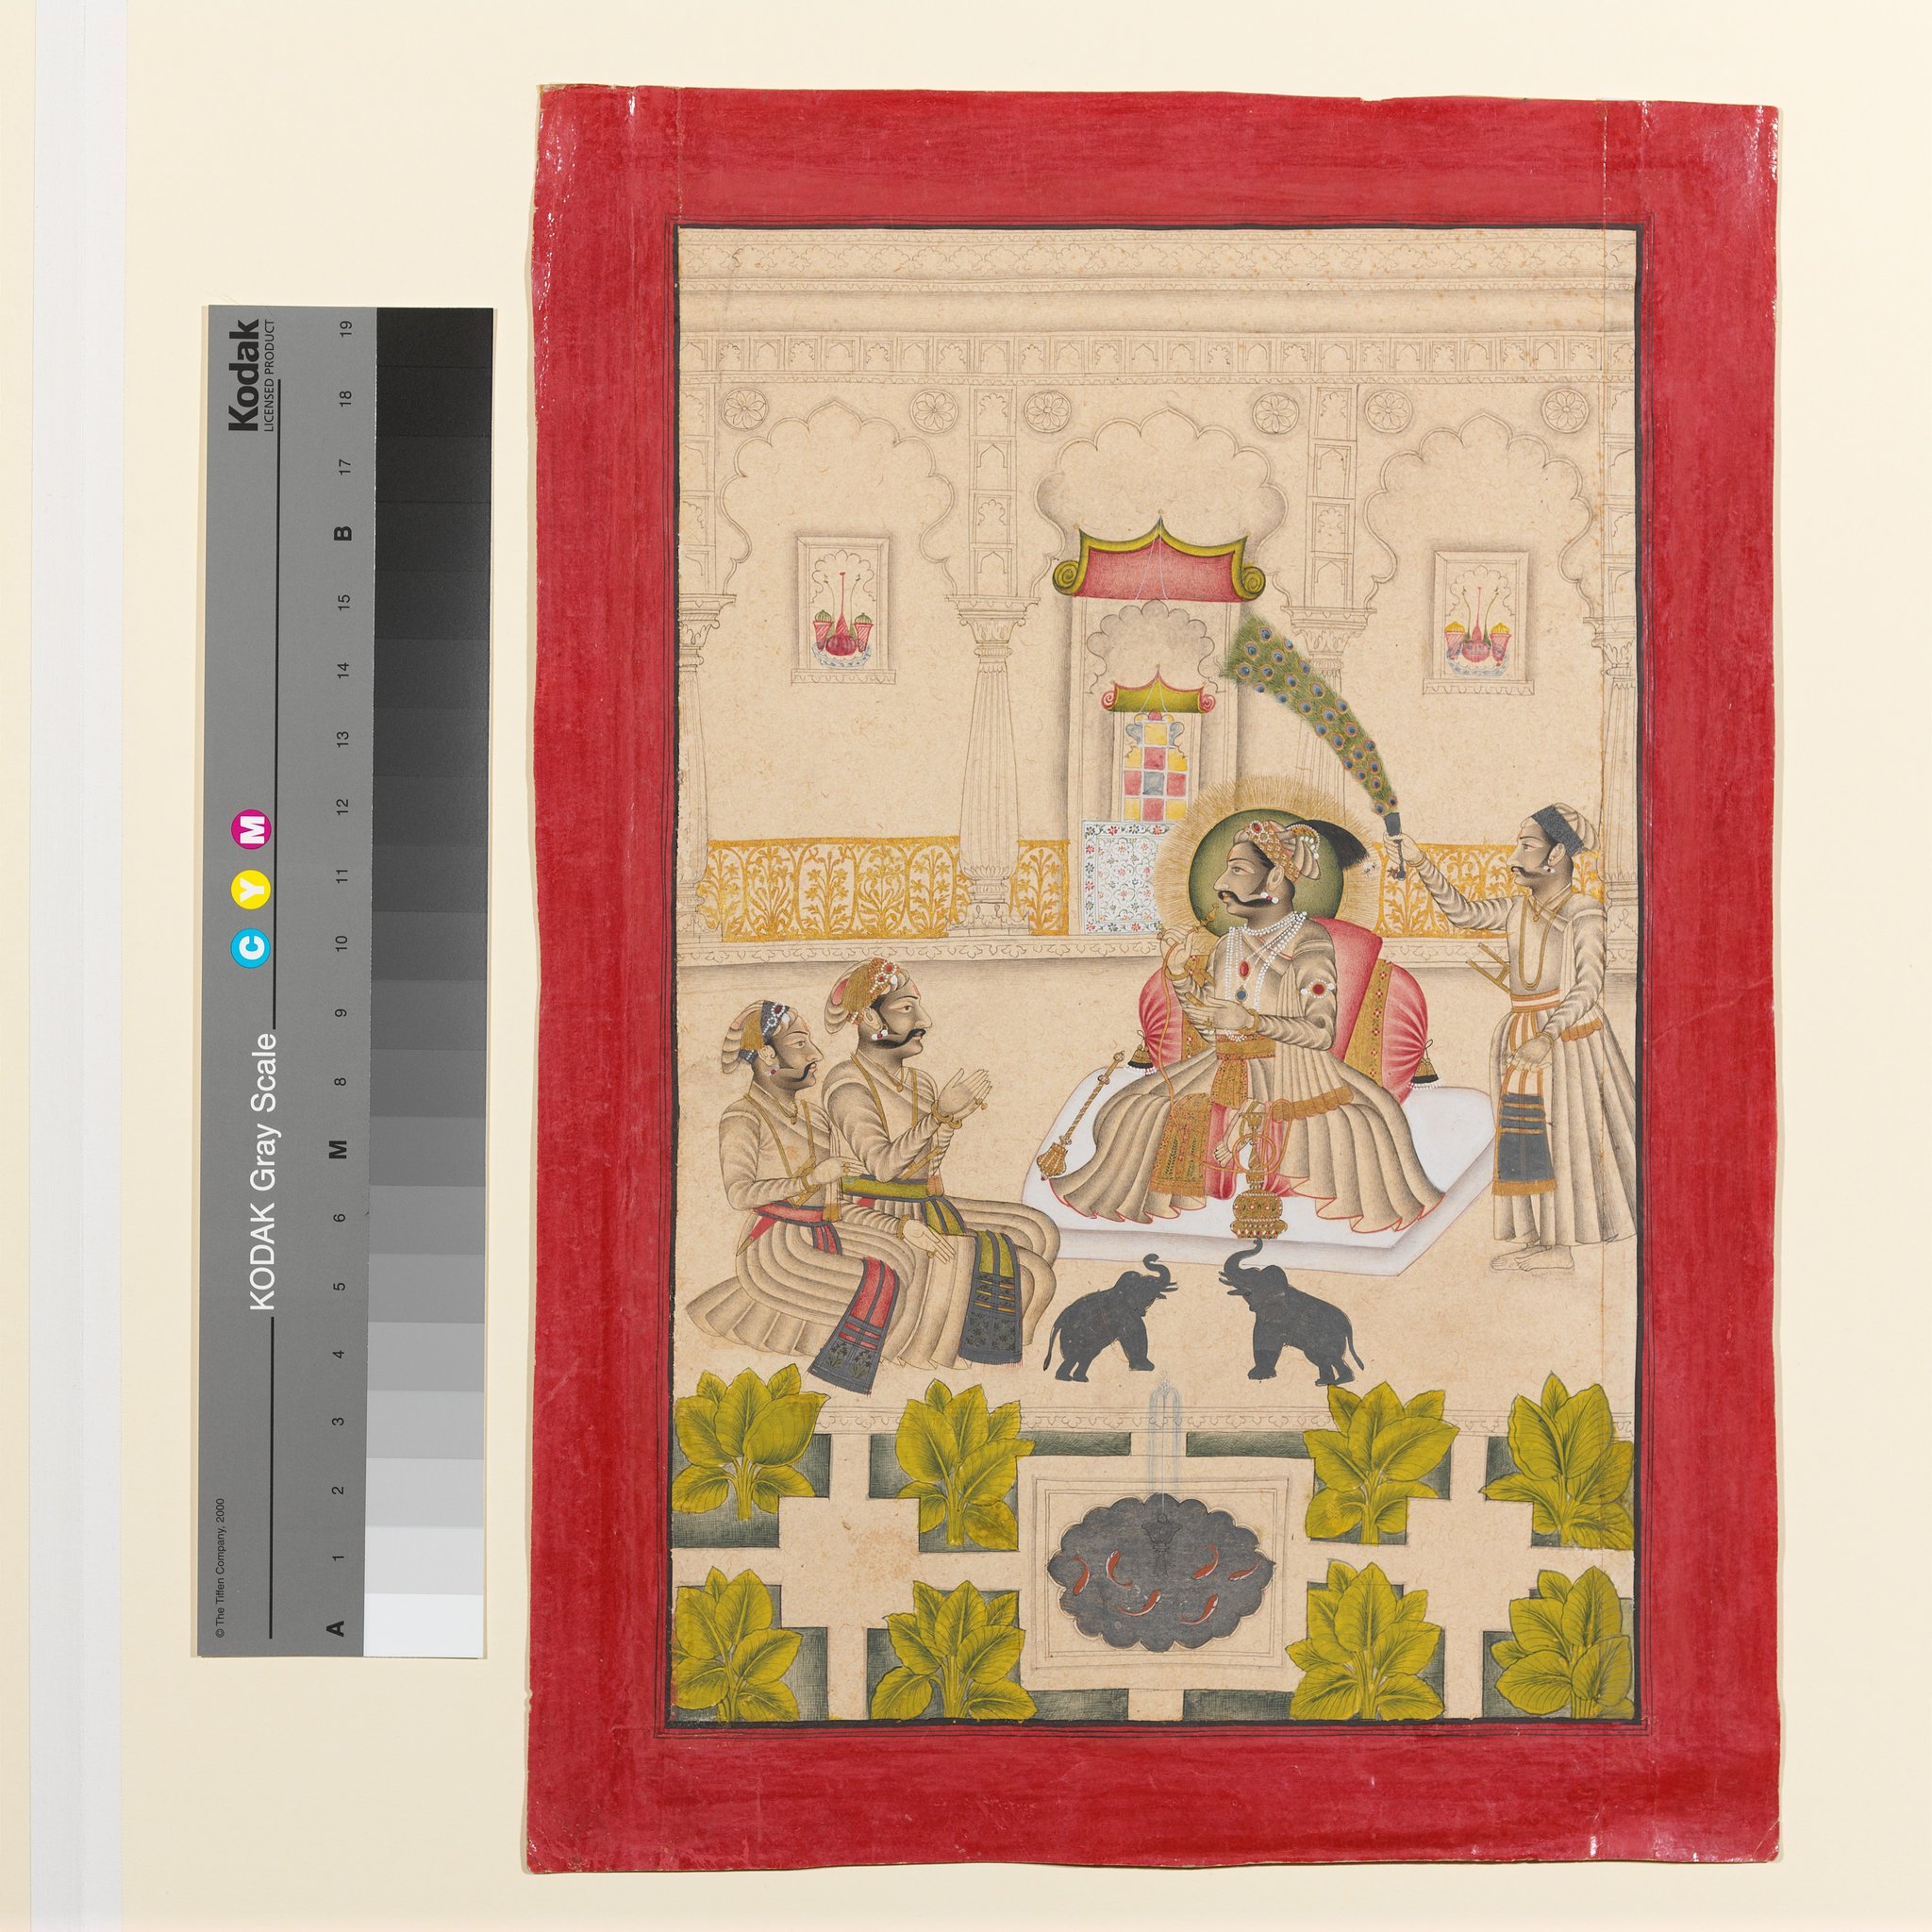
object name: painting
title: Maharana Amar Singh II Is Shown Two Silver Elephants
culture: mewar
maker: stipple master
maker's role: artist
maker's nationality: indian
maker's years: 1680-1725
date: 1705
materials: gold, ink, paper, silver, watercolor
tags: fountains,men,smoking,elephants,fish,hookah